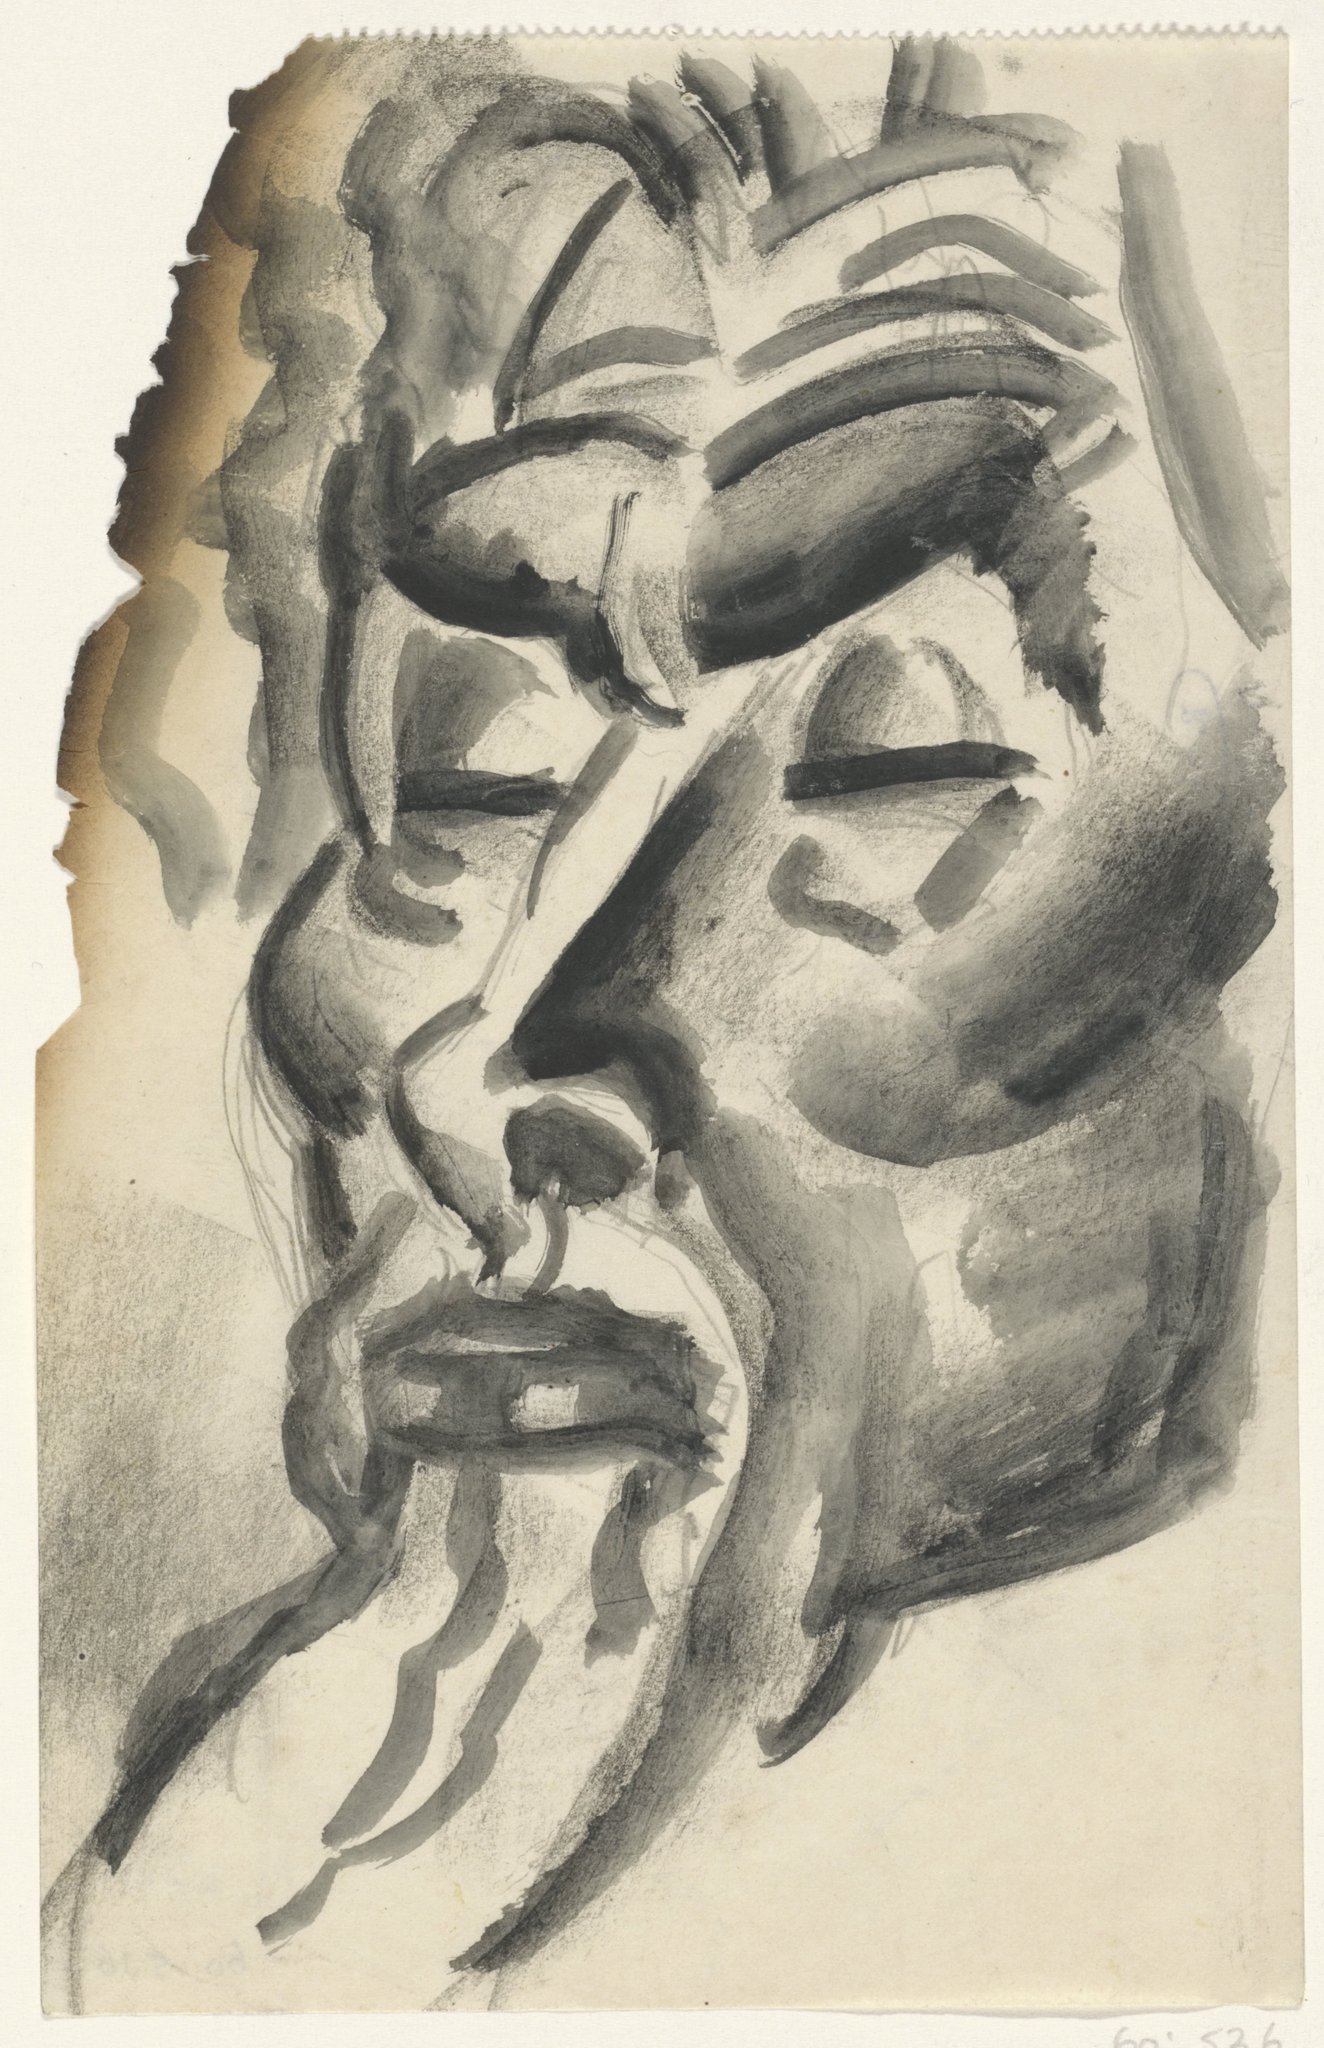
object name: drawing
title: Portret van Jan Toorop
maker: leo gestel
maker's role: draughtsman, print maker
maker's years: 1881-1941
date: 1920-1922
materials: chalk, paper, pencil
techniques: brush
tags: the hague, print maker, draughtsman, jan toorop, historical persons, portrait, self-portrait of draughtsman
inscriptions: collector's mark: Lugt 2228